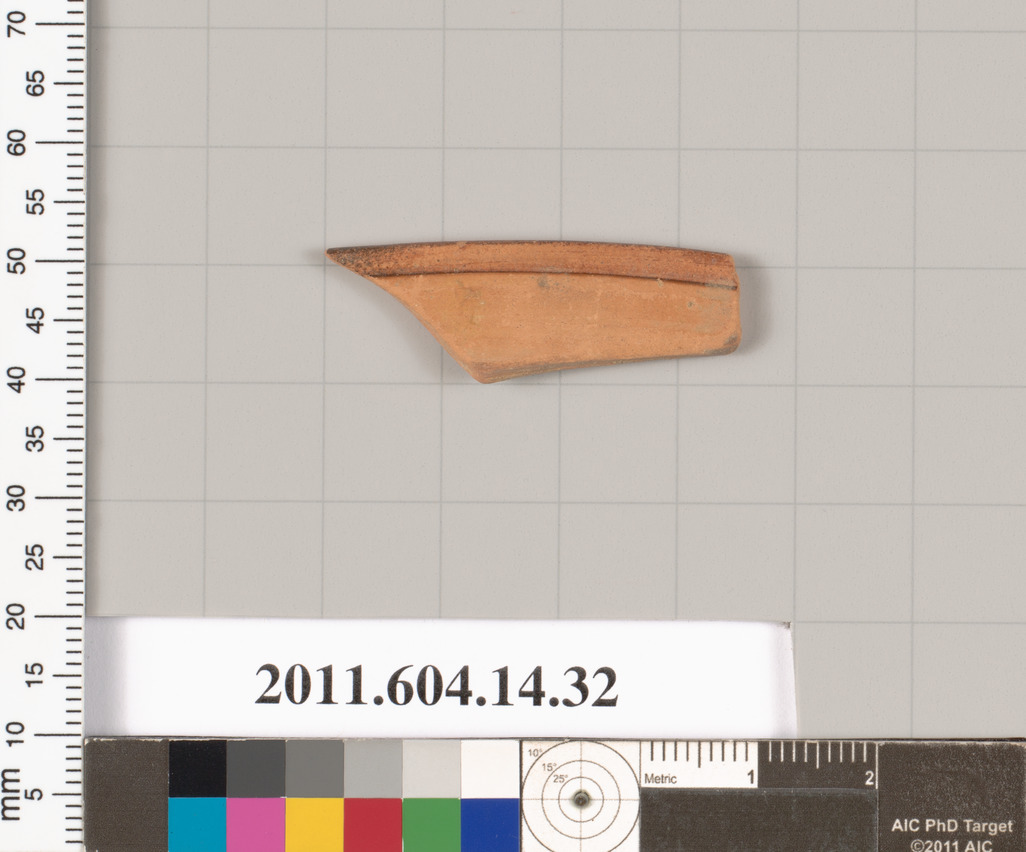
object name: kylix fragment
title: Terracotta fragment of a rim fragment of a kylix (drinking cup)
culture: unknown fabric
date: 600-401 BCE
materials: terracotta